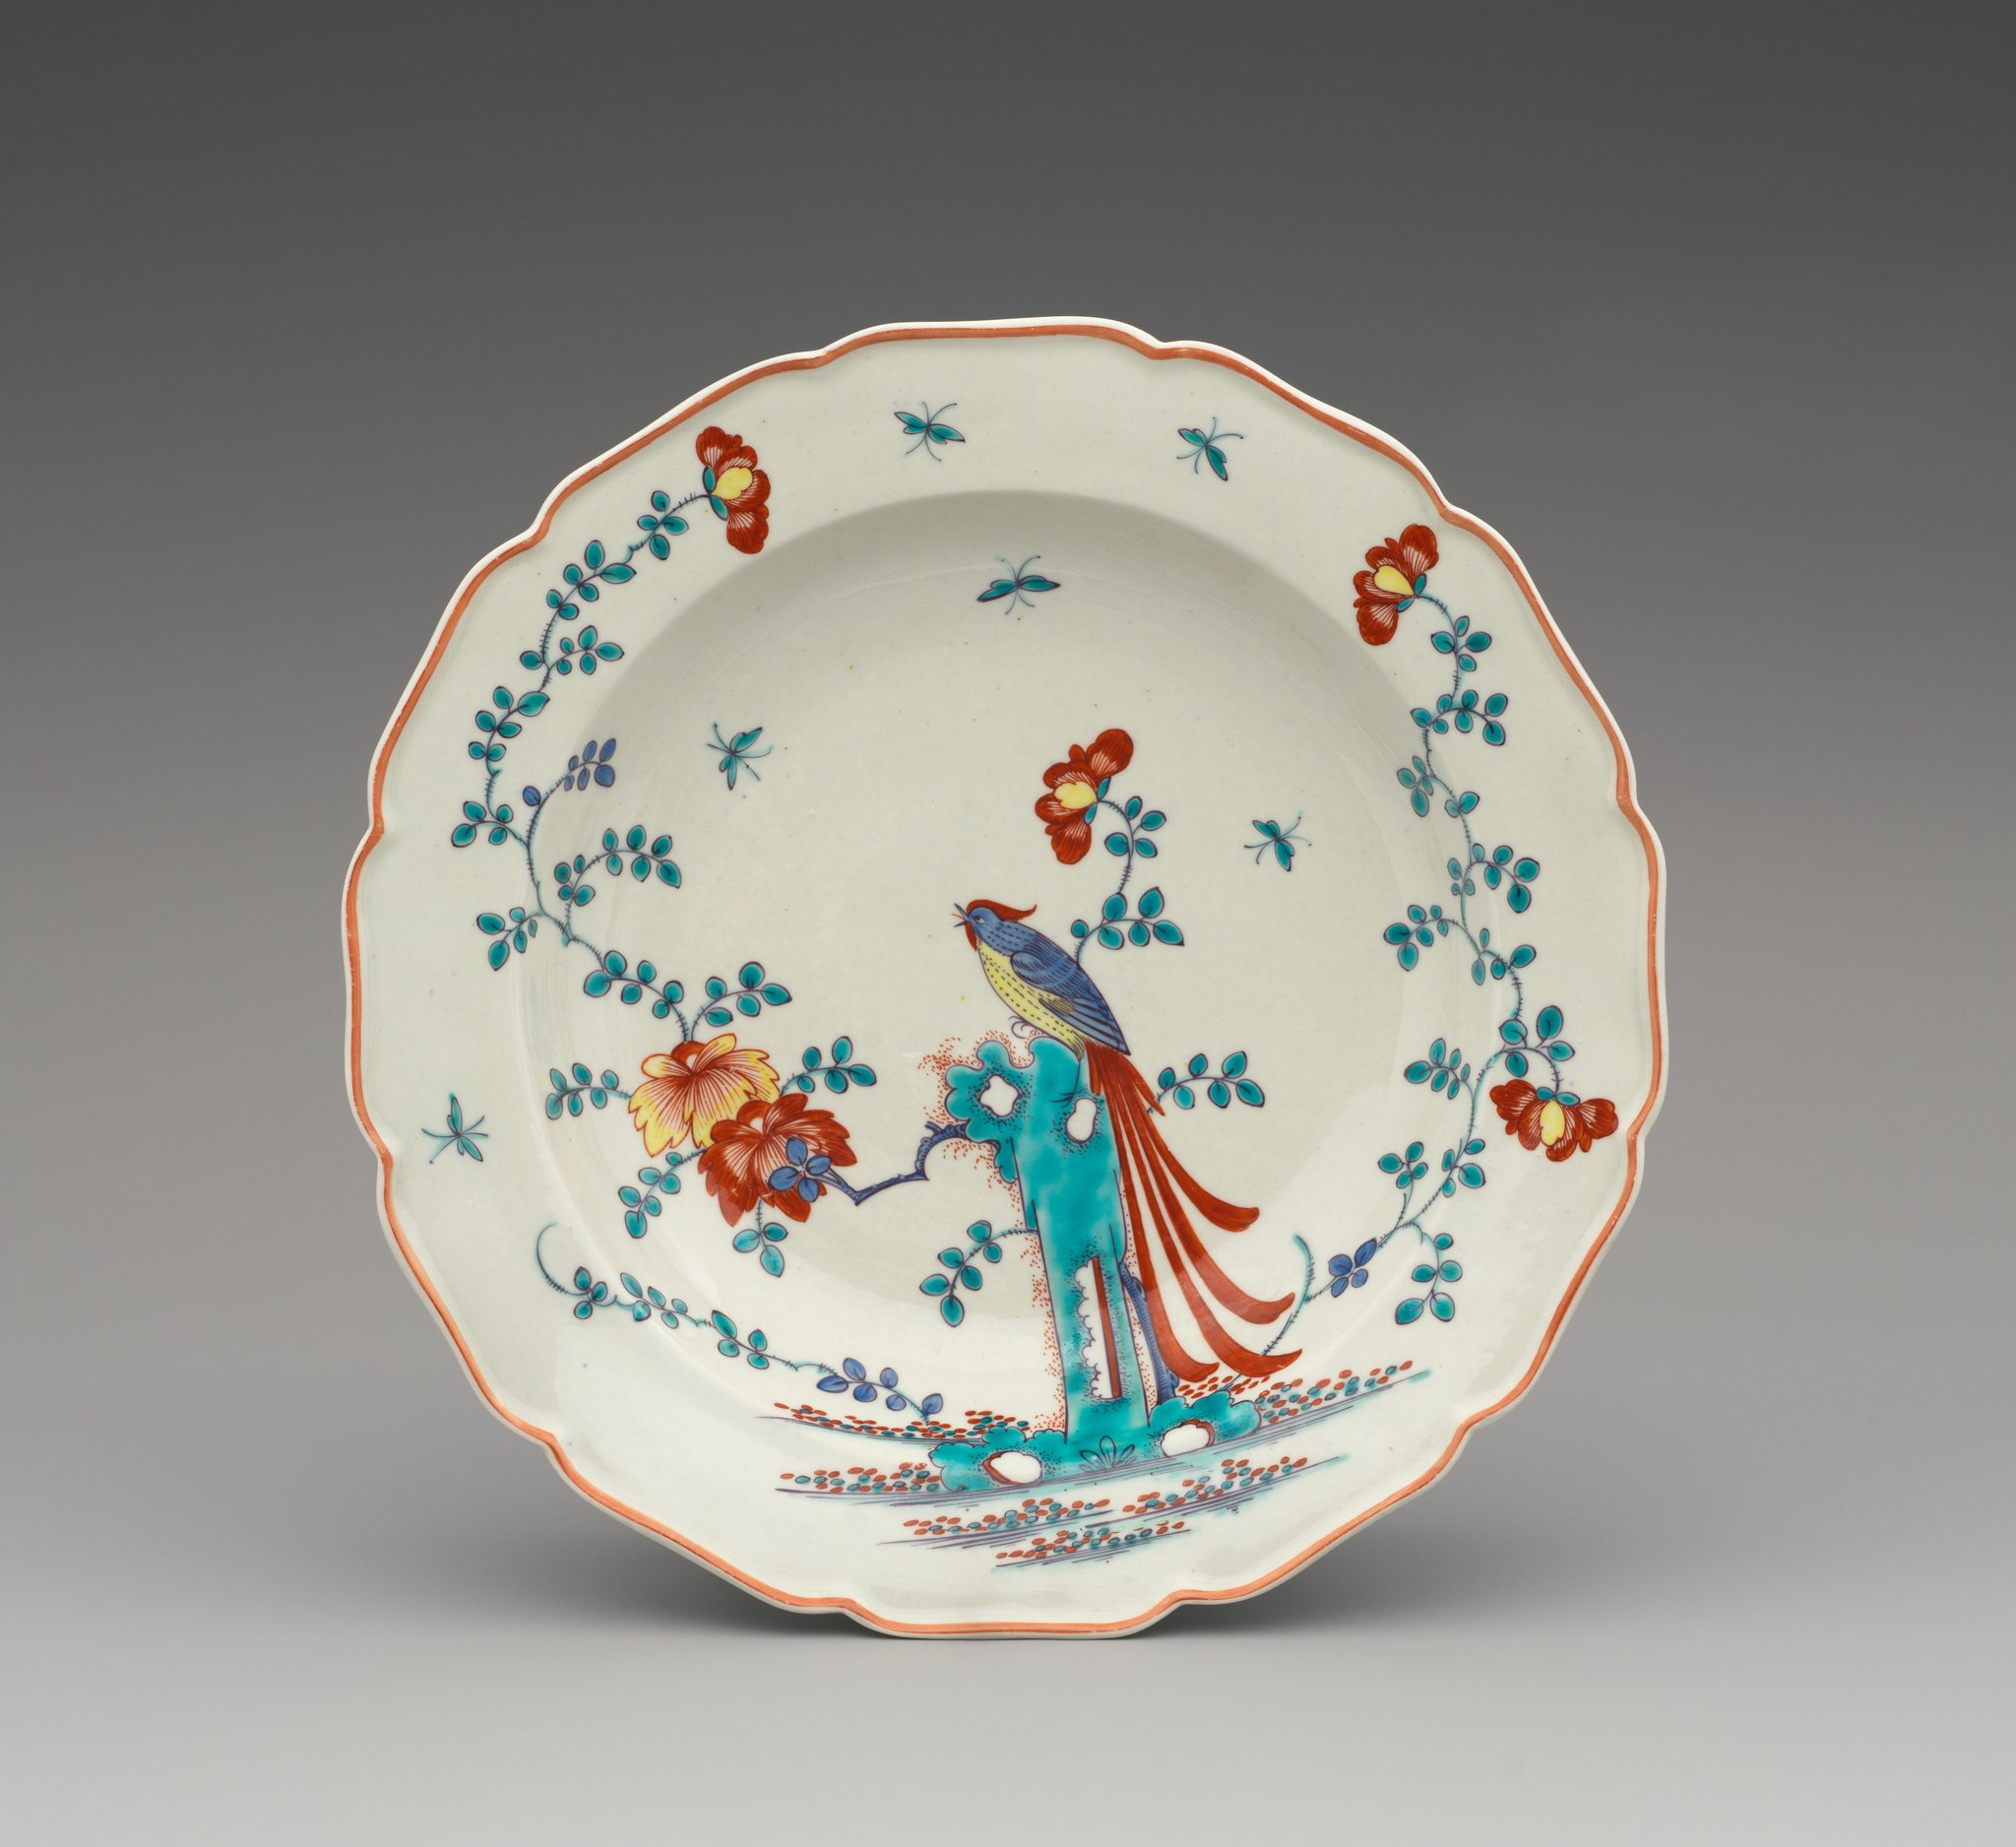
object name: dish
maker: worcester factory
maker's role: factory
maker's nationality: british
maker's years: 1751-2008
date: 1770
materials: soft paste porcelain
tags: birds